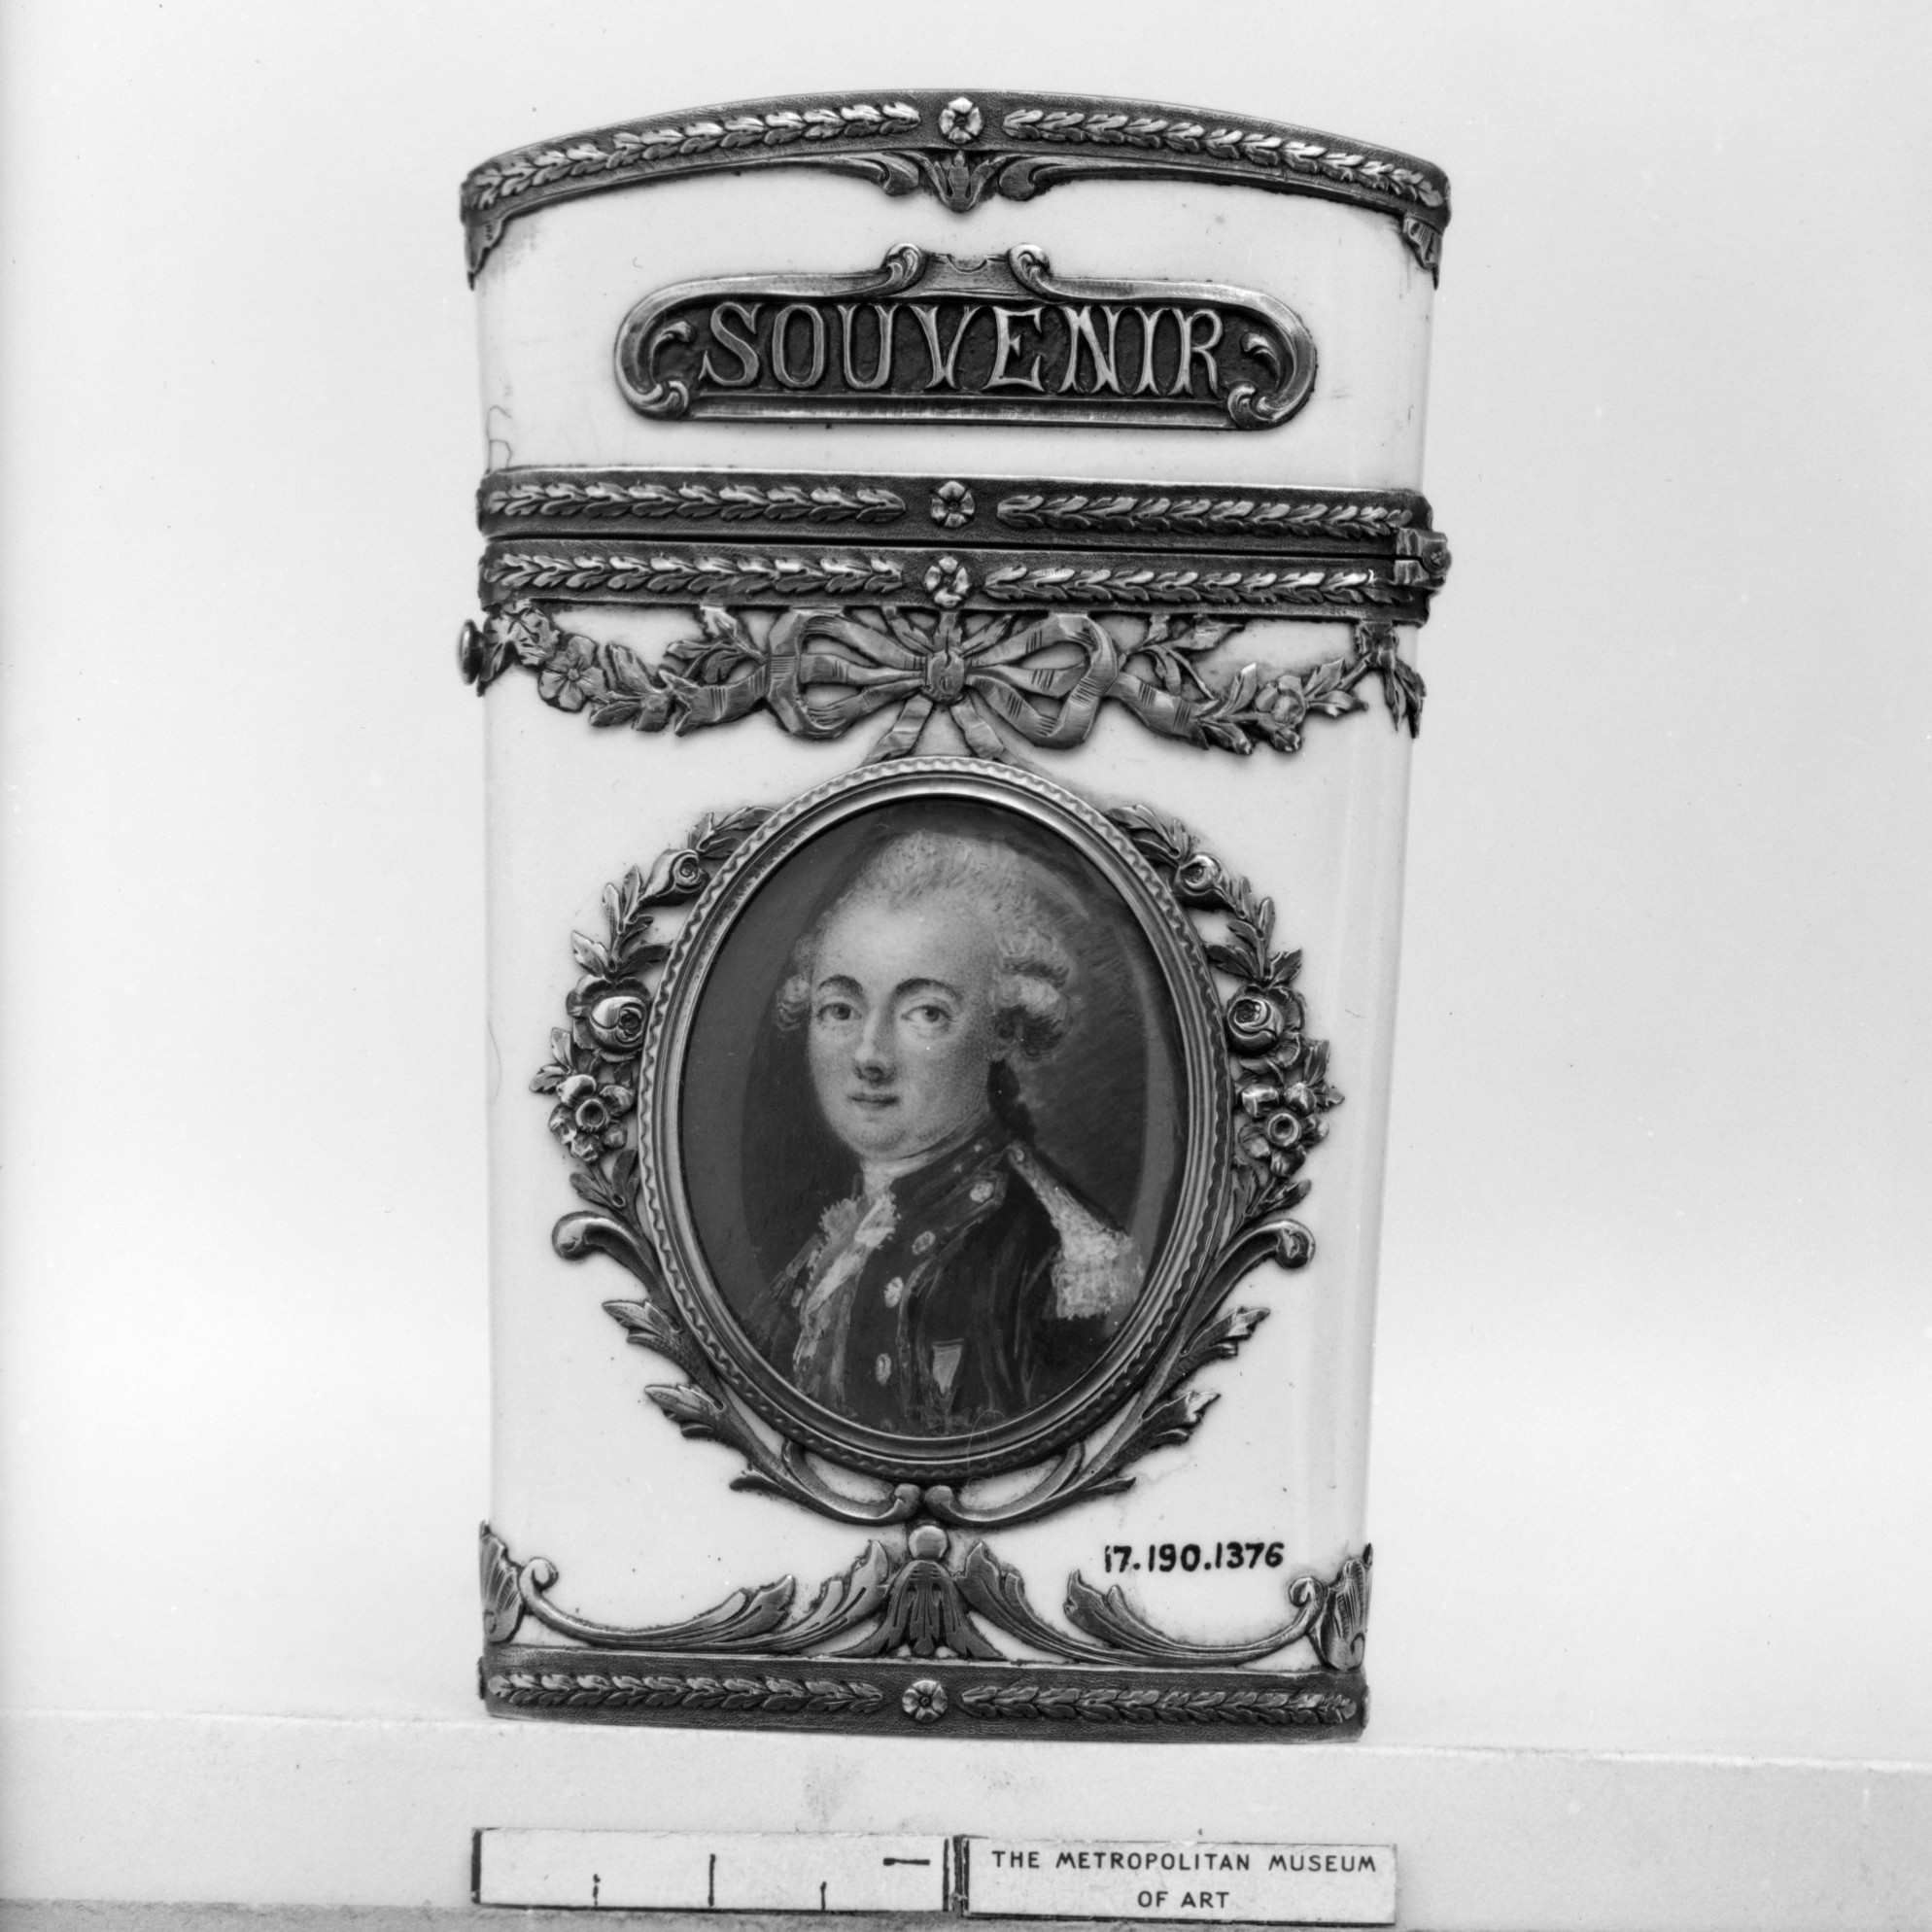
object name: souvenir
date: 1801-1900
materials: enamel, gold, ivory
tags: men,portraits